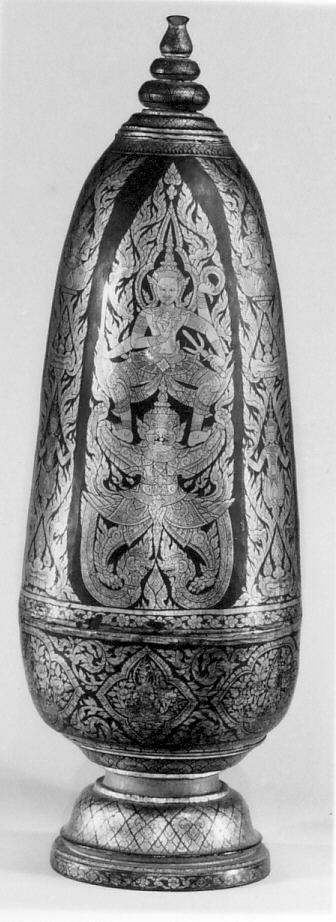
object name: headdress box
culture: thai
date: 1701-1800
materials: gold